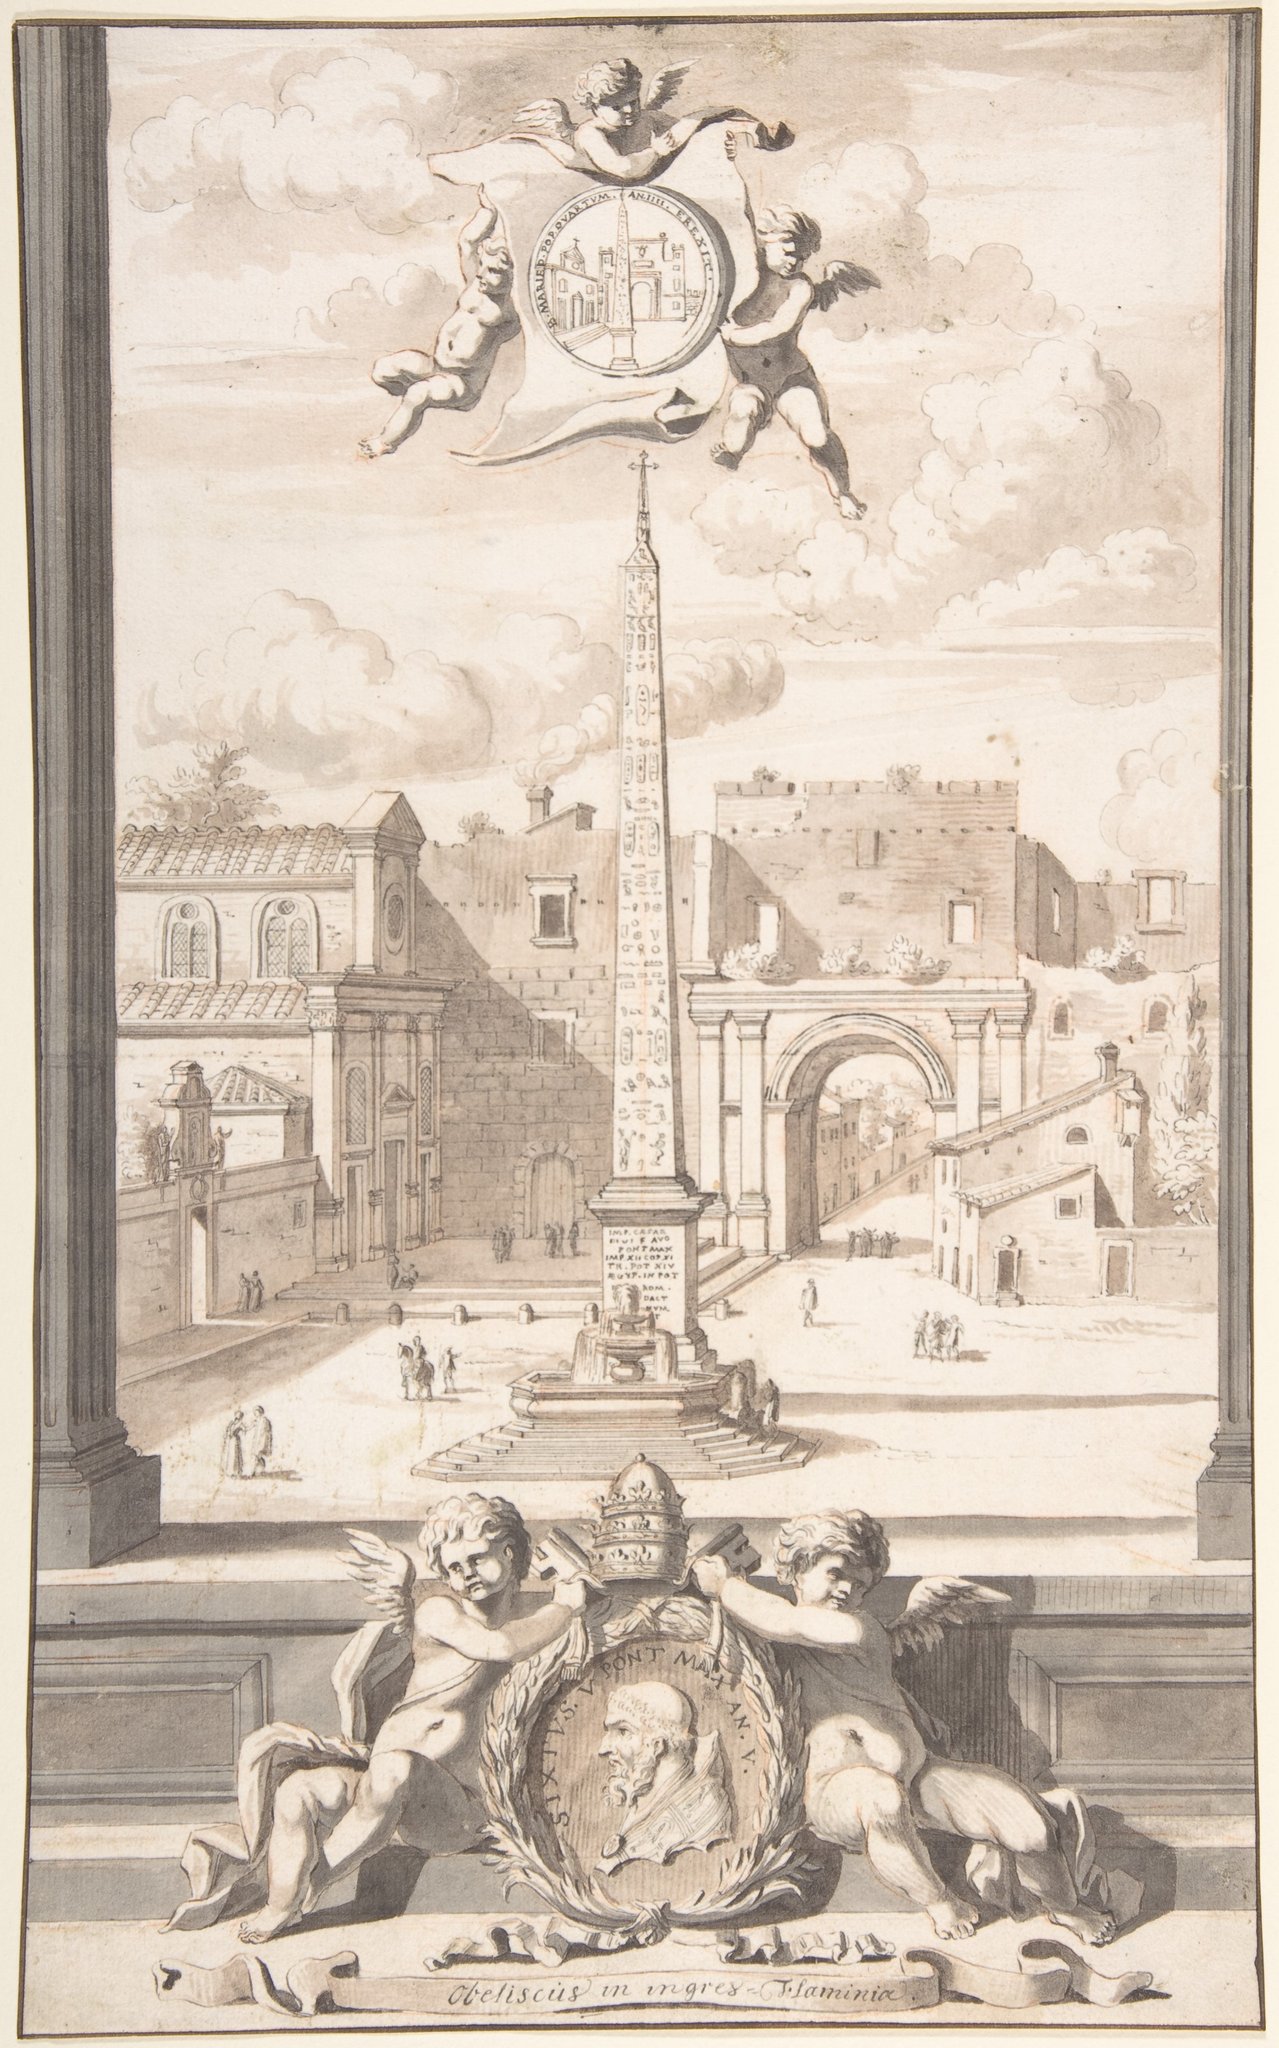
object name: drawing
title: A Reconstruction of a View of the Obelisk at the Entrance of the Via Flaminia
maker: jan goeree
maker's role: artist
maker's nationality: dutch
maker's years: 1670-1731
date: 1704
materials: chalk, ink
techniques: brush, incising, pen, wash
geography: italy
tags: buildings,obelisks,men,profiles